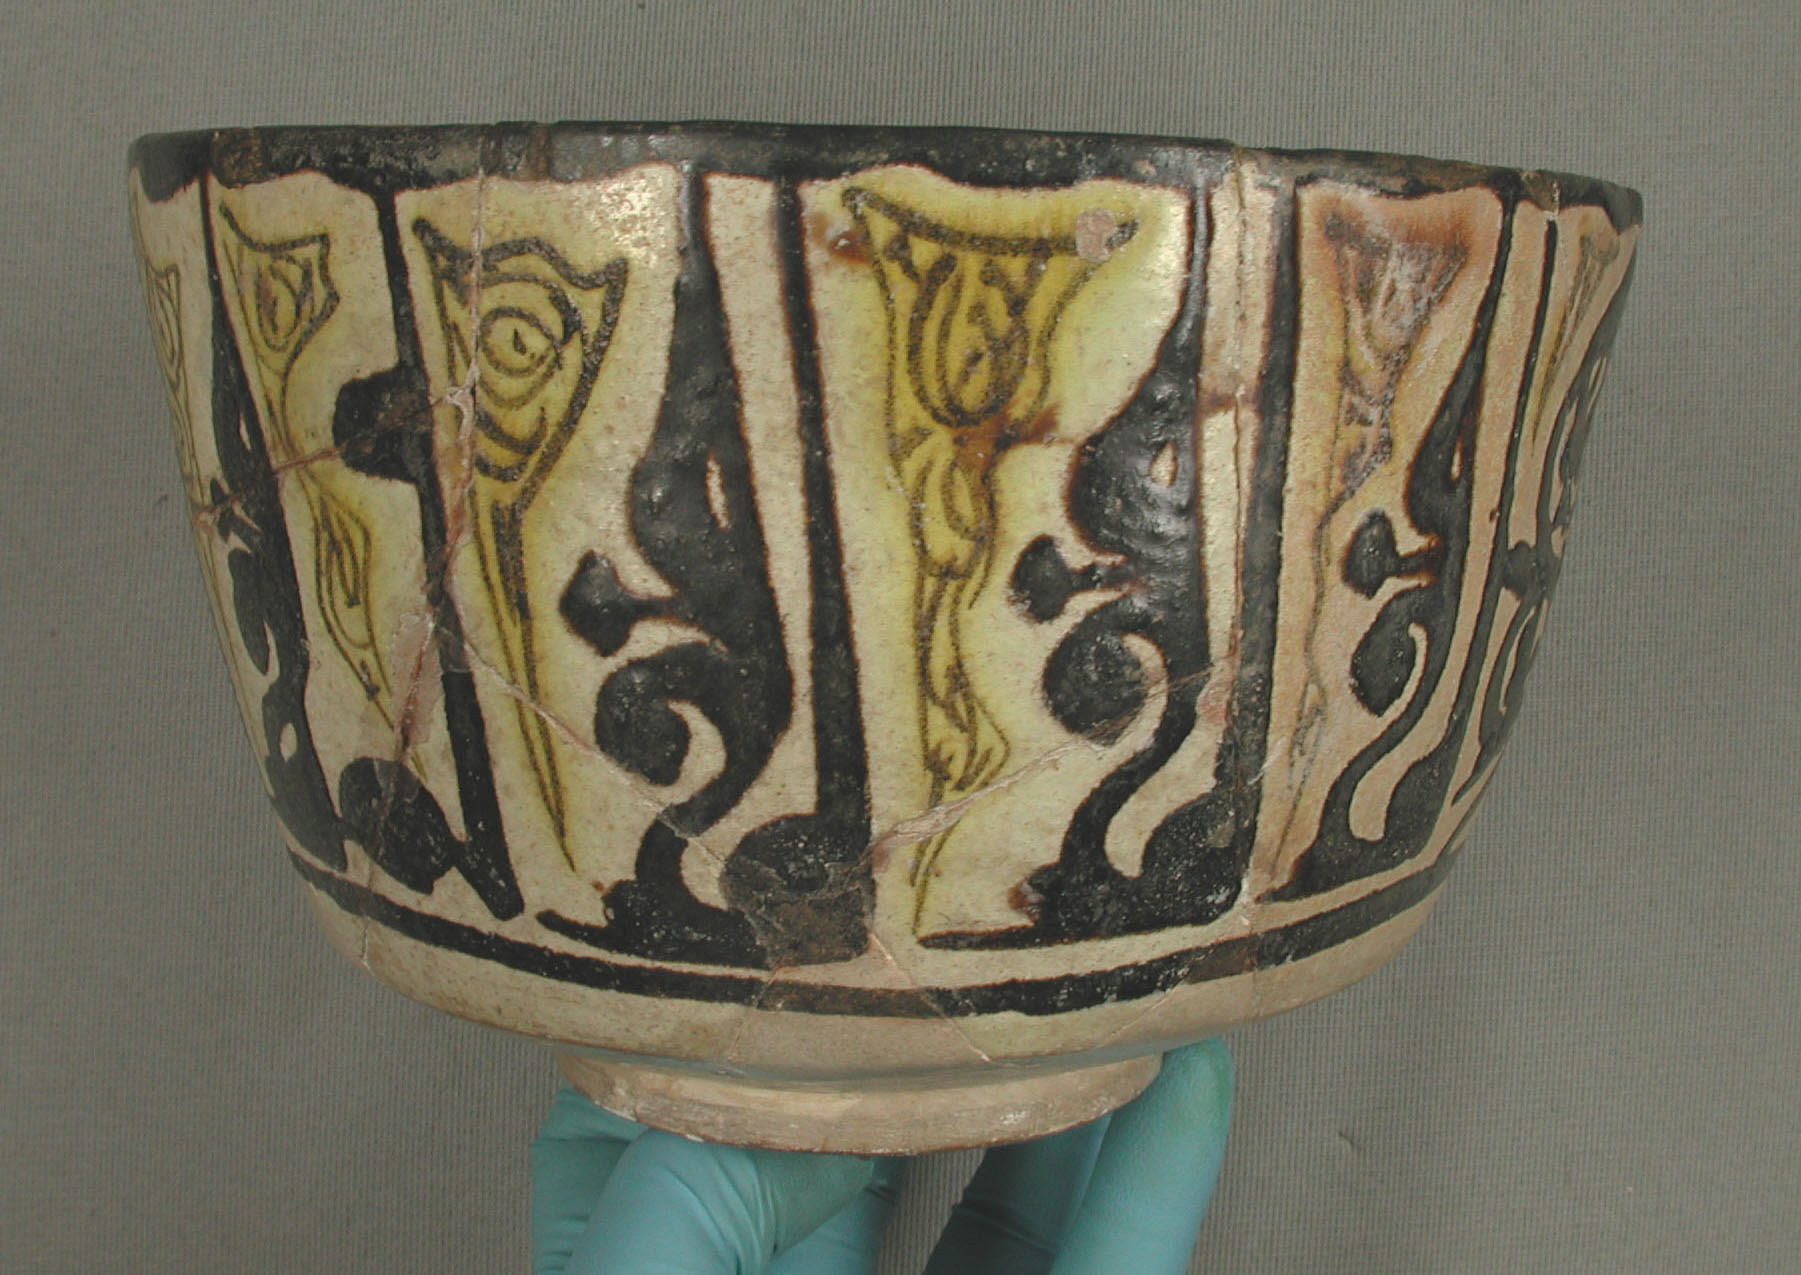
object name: bowl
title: Bowl with Repeating Inscription, "Happiness"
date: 801-1000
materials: earthenware, glaze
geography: iran